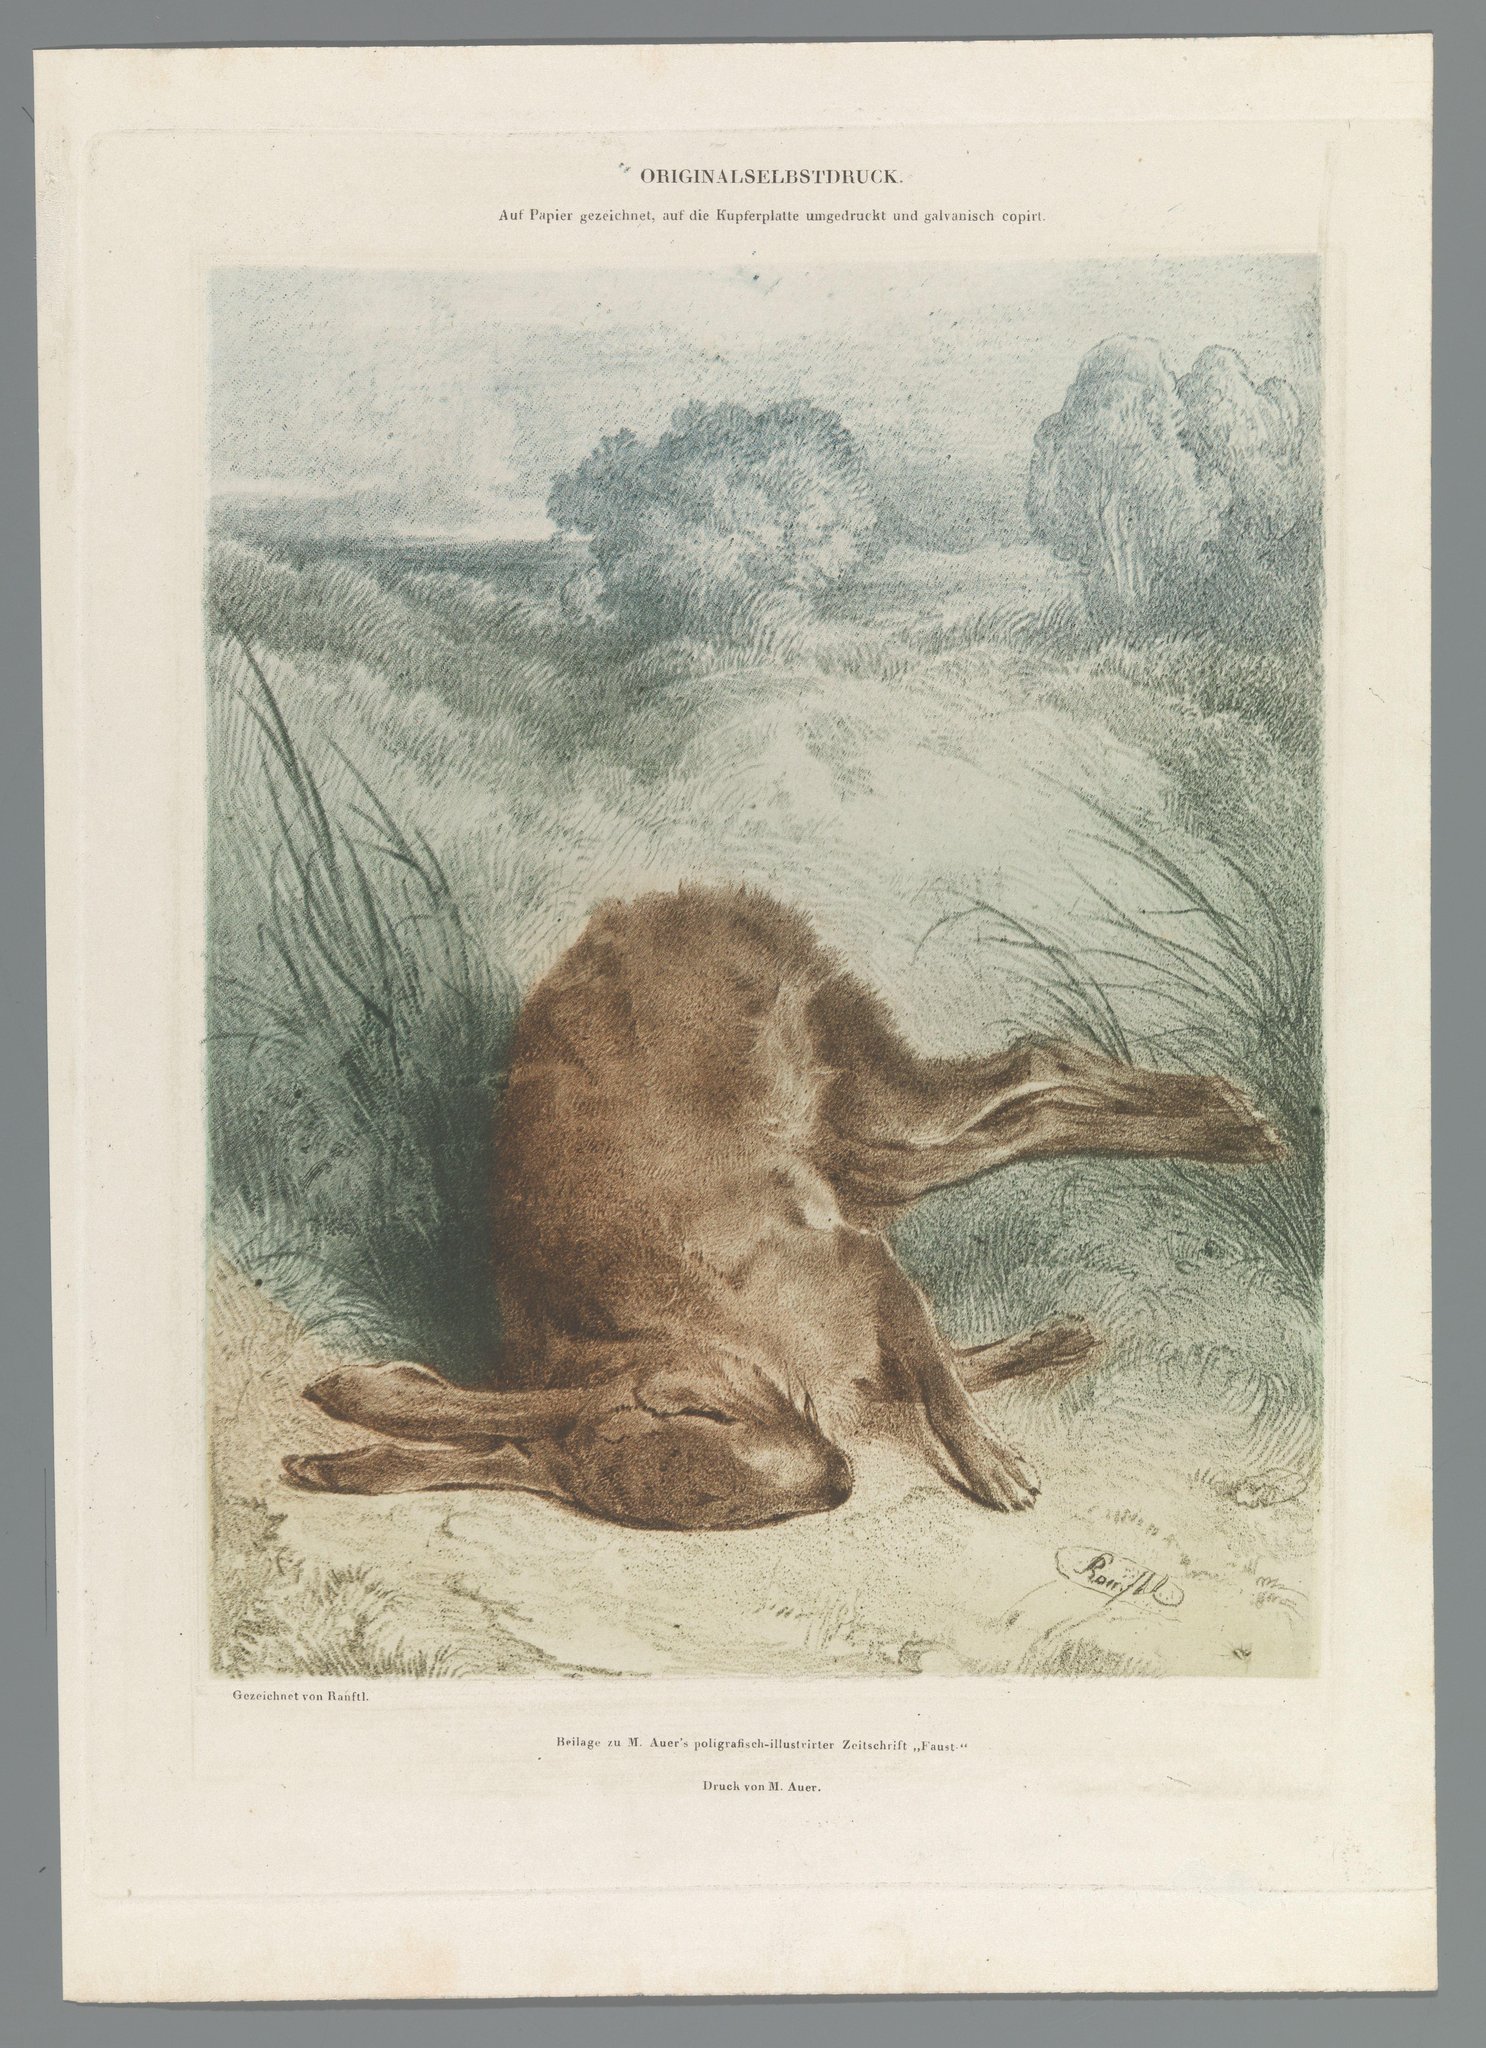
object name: photomechanical print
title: Dode haas in een veld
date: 1855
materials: paper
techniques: photogalvanography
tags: rodents: hare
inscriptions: inscription: ‘ORIGINALSELBSTDRUCK./ Auf Papier gezeichnet, auf die Kupferplatte umgedruckt und galvanisch copirt.’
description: Blad uit reeks van 16 Naturselbstdrucke Auer.